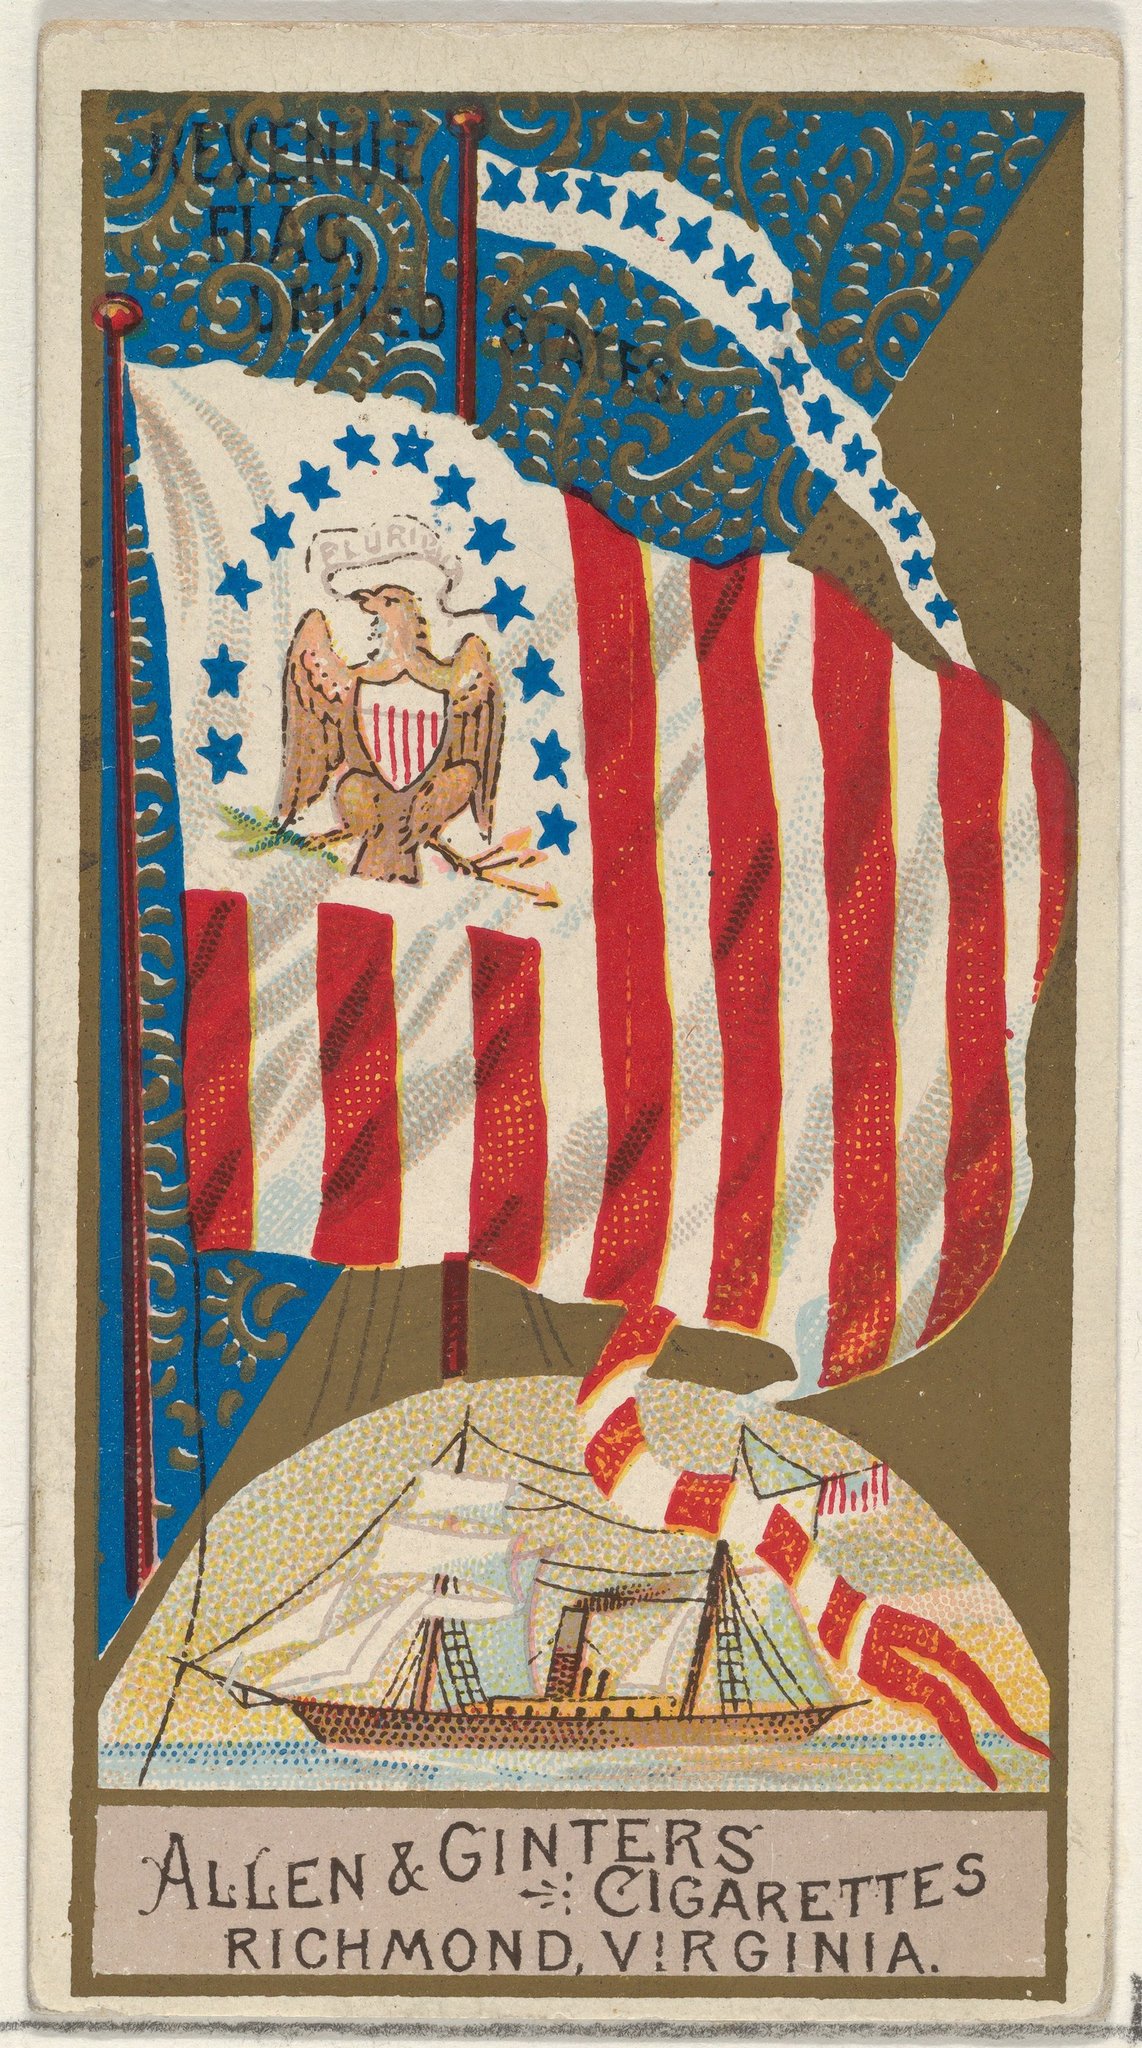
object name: print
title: Revenue Flag, United States, from the Naval Flags series (N17) for Allen & Ginter Cigarettes Brands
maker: allen & ginter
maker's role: publisher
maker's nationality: american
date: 1888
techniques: color lithograph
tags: flags